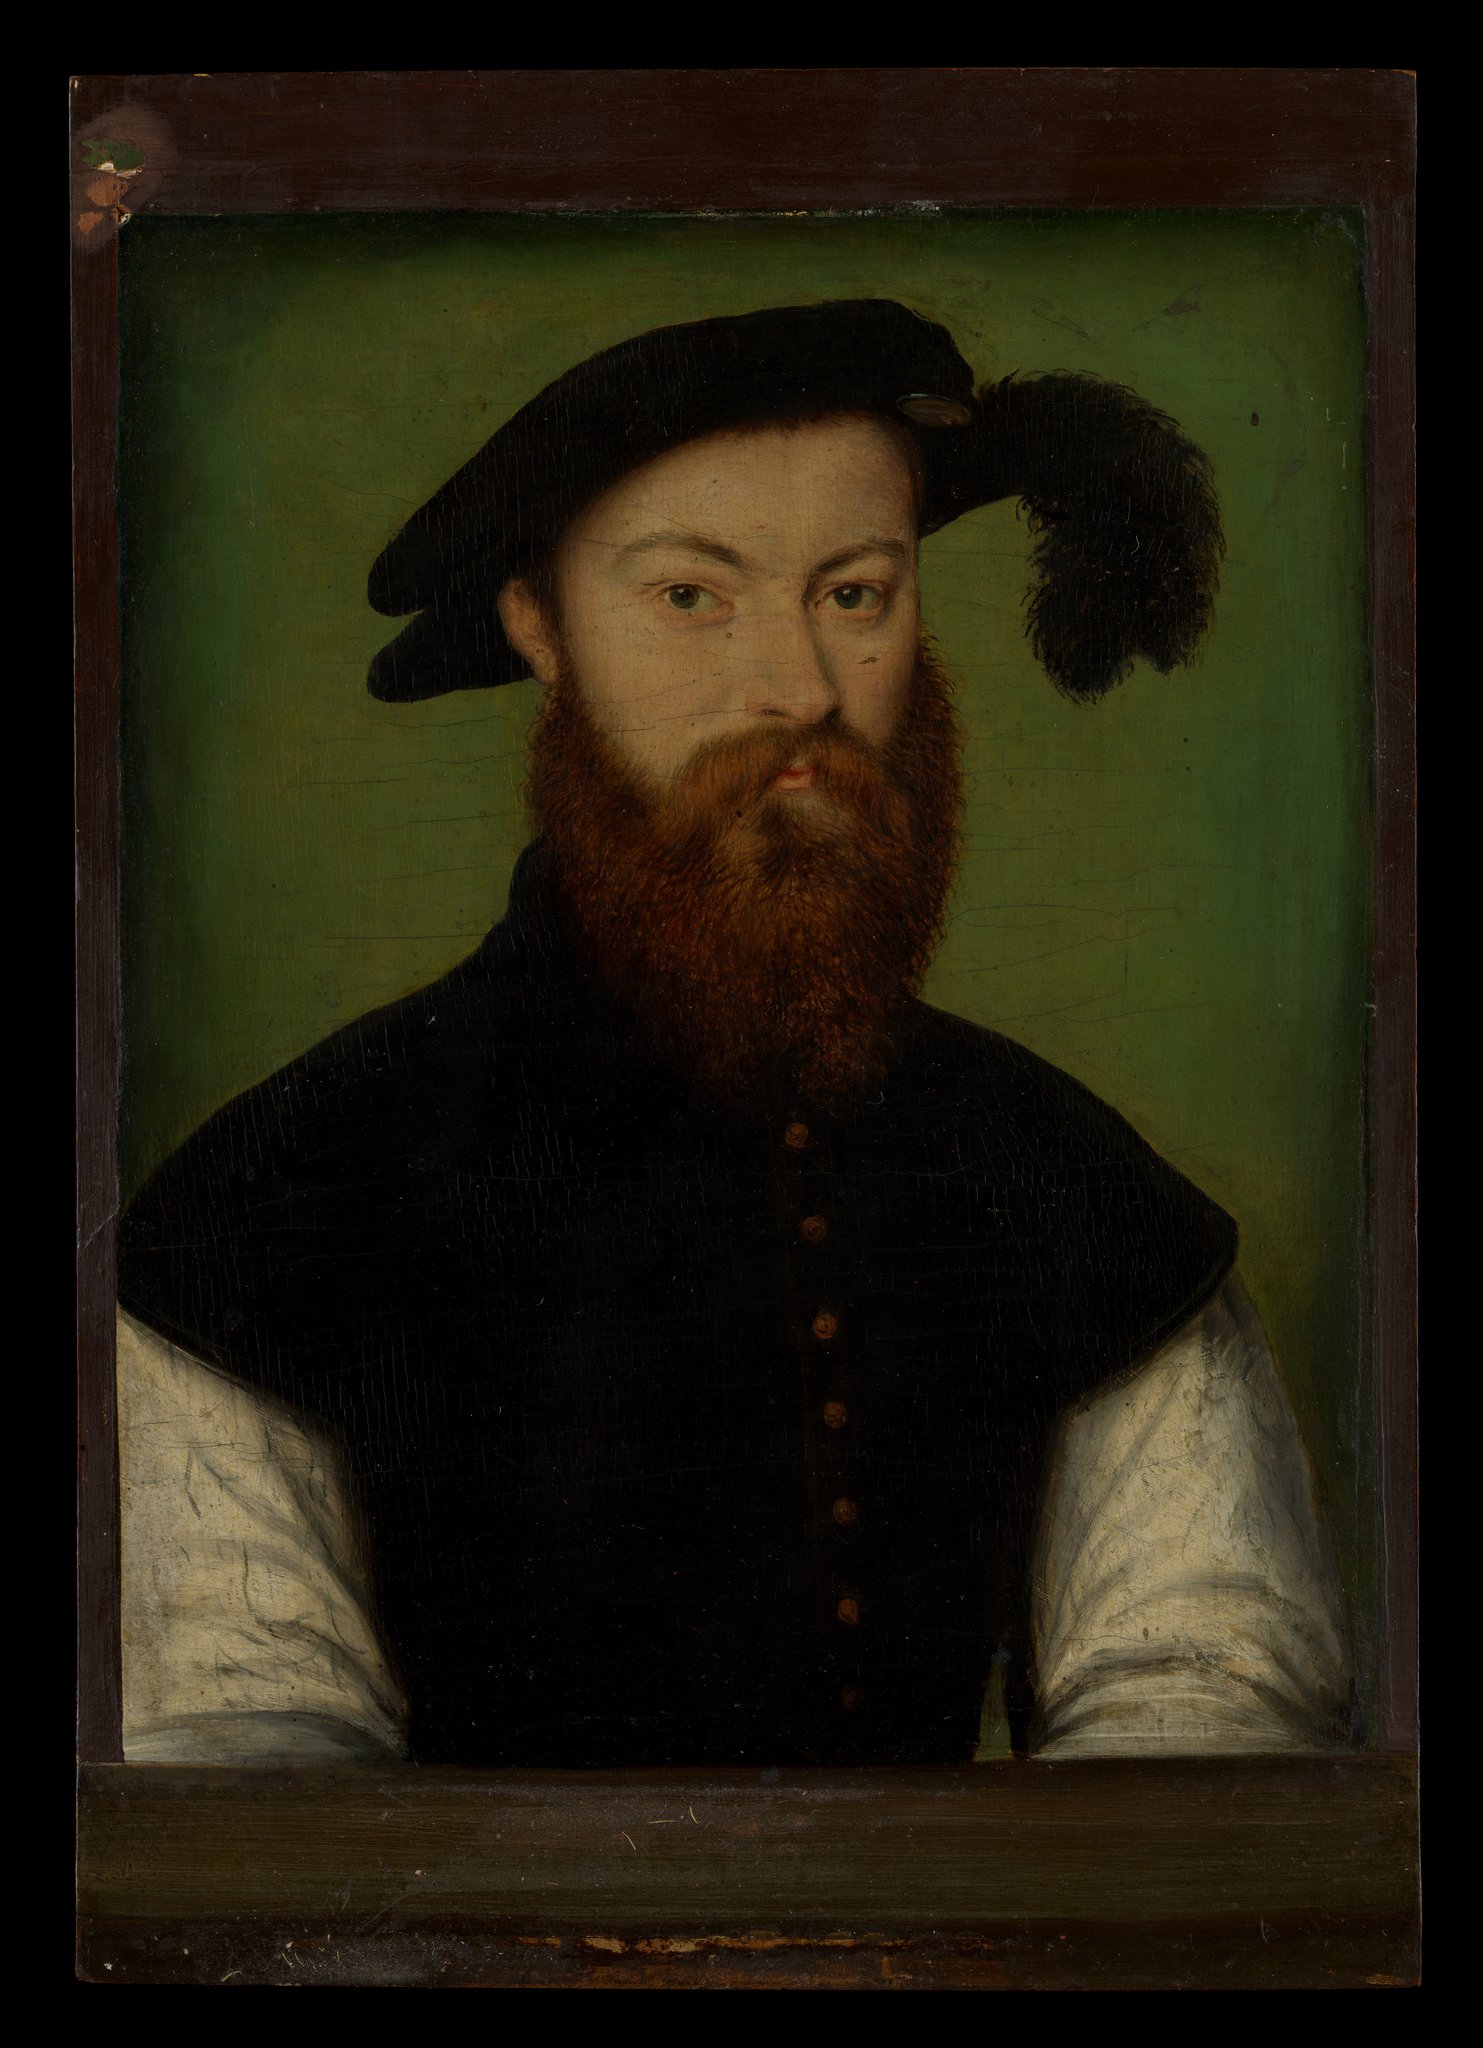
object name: painting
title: Portrait of a Man with a Black-Plumed Hat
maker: corneille de lyon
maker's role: artist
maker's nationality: netherlandish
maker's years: 1533-1575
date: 1535-1540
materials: oil, wood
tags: men,portraits